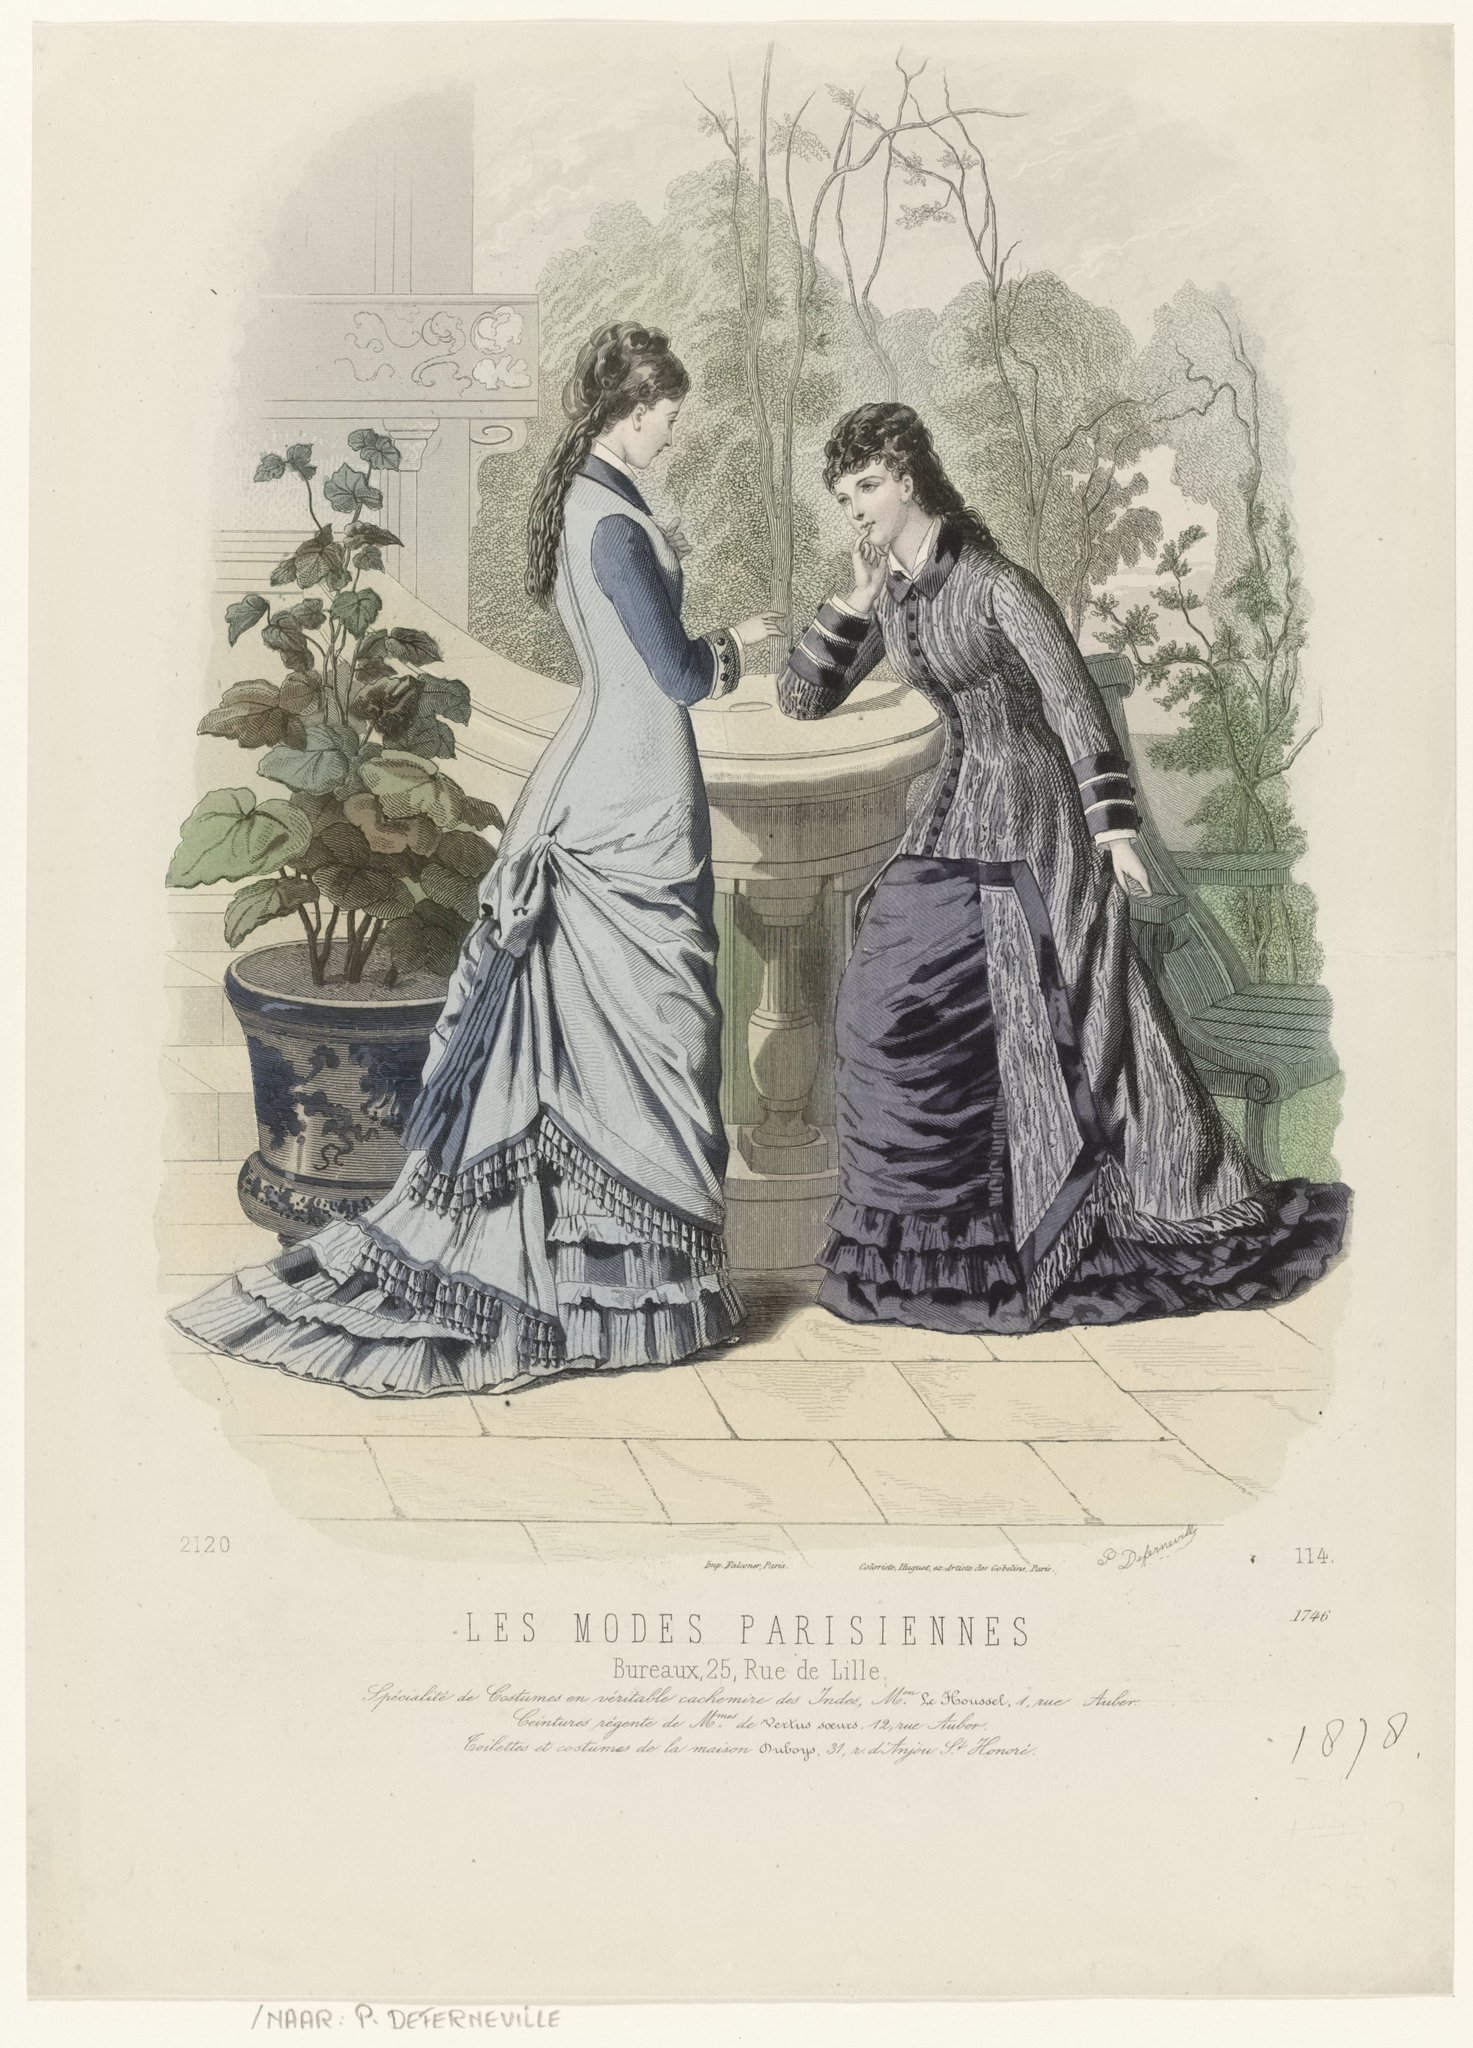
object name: fashion print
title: Les Modes Parisiennes, 1878, No. 1746 : Spécialité de Costumes (...)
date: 1878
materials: paper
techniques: engraving, hand coloring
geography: paris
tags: fashion plates, skirt (+ women's clothes), dress, gown (+ women's clothes), terrace, garden vase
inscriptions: caption: ‘Spécialité de Costumes en véritables cachemire des Indes, M.on Le Houssel, 1, rue Auber. Ceintures régente de Mmes de Vertus soeurs,12, rue Auber. Toilettes et costumes de la maison Duboys, 31,r. d'Anjou S.t Honoré.’, address: ‘Bureaux, 25, Rue de Lille.’, title: ‘LES MODES PARISIENNES’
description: Twee vrouwen op een terras bij een balustrade. Onder de voorstelling enkele regels reclametekst voor verschillende producten. Volgens het onderschrift: 'toilettes' en kostuums van Maison Duboys. Prent uit het modetijdschrift Les Modes Parisiennes (1843-1885).